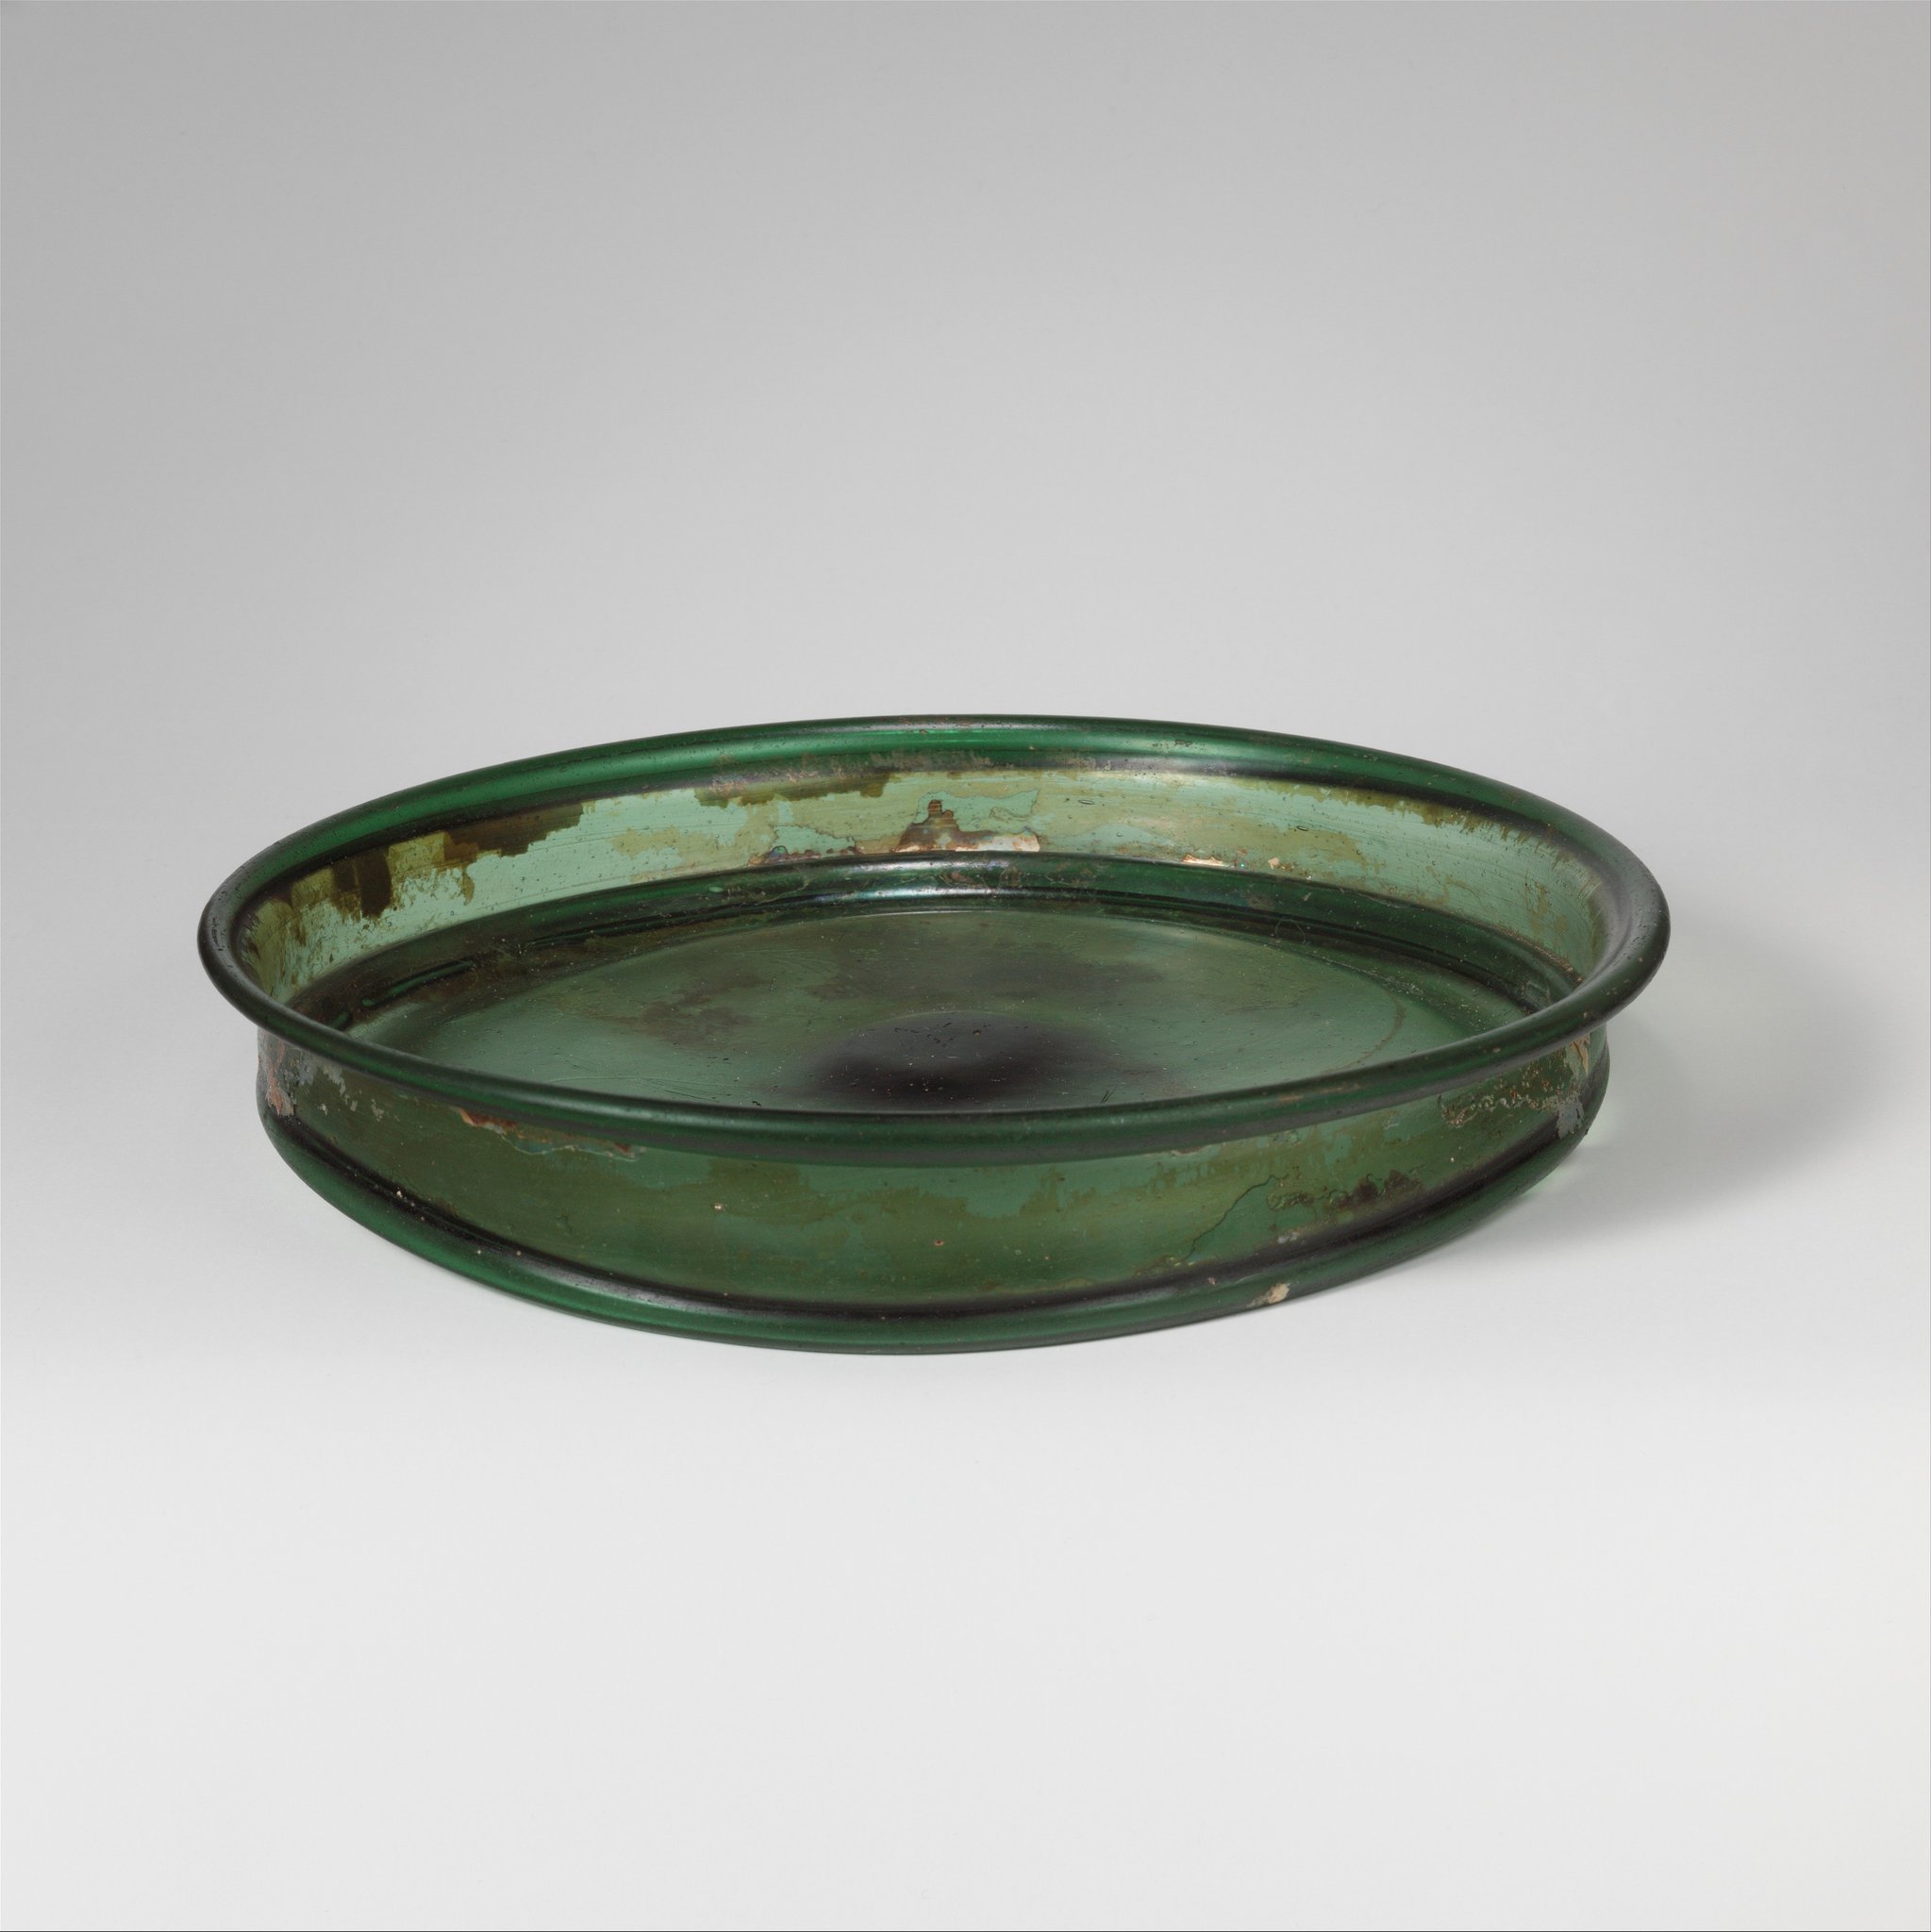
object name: dish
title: Glass dish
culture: roman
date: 1-100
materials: glass